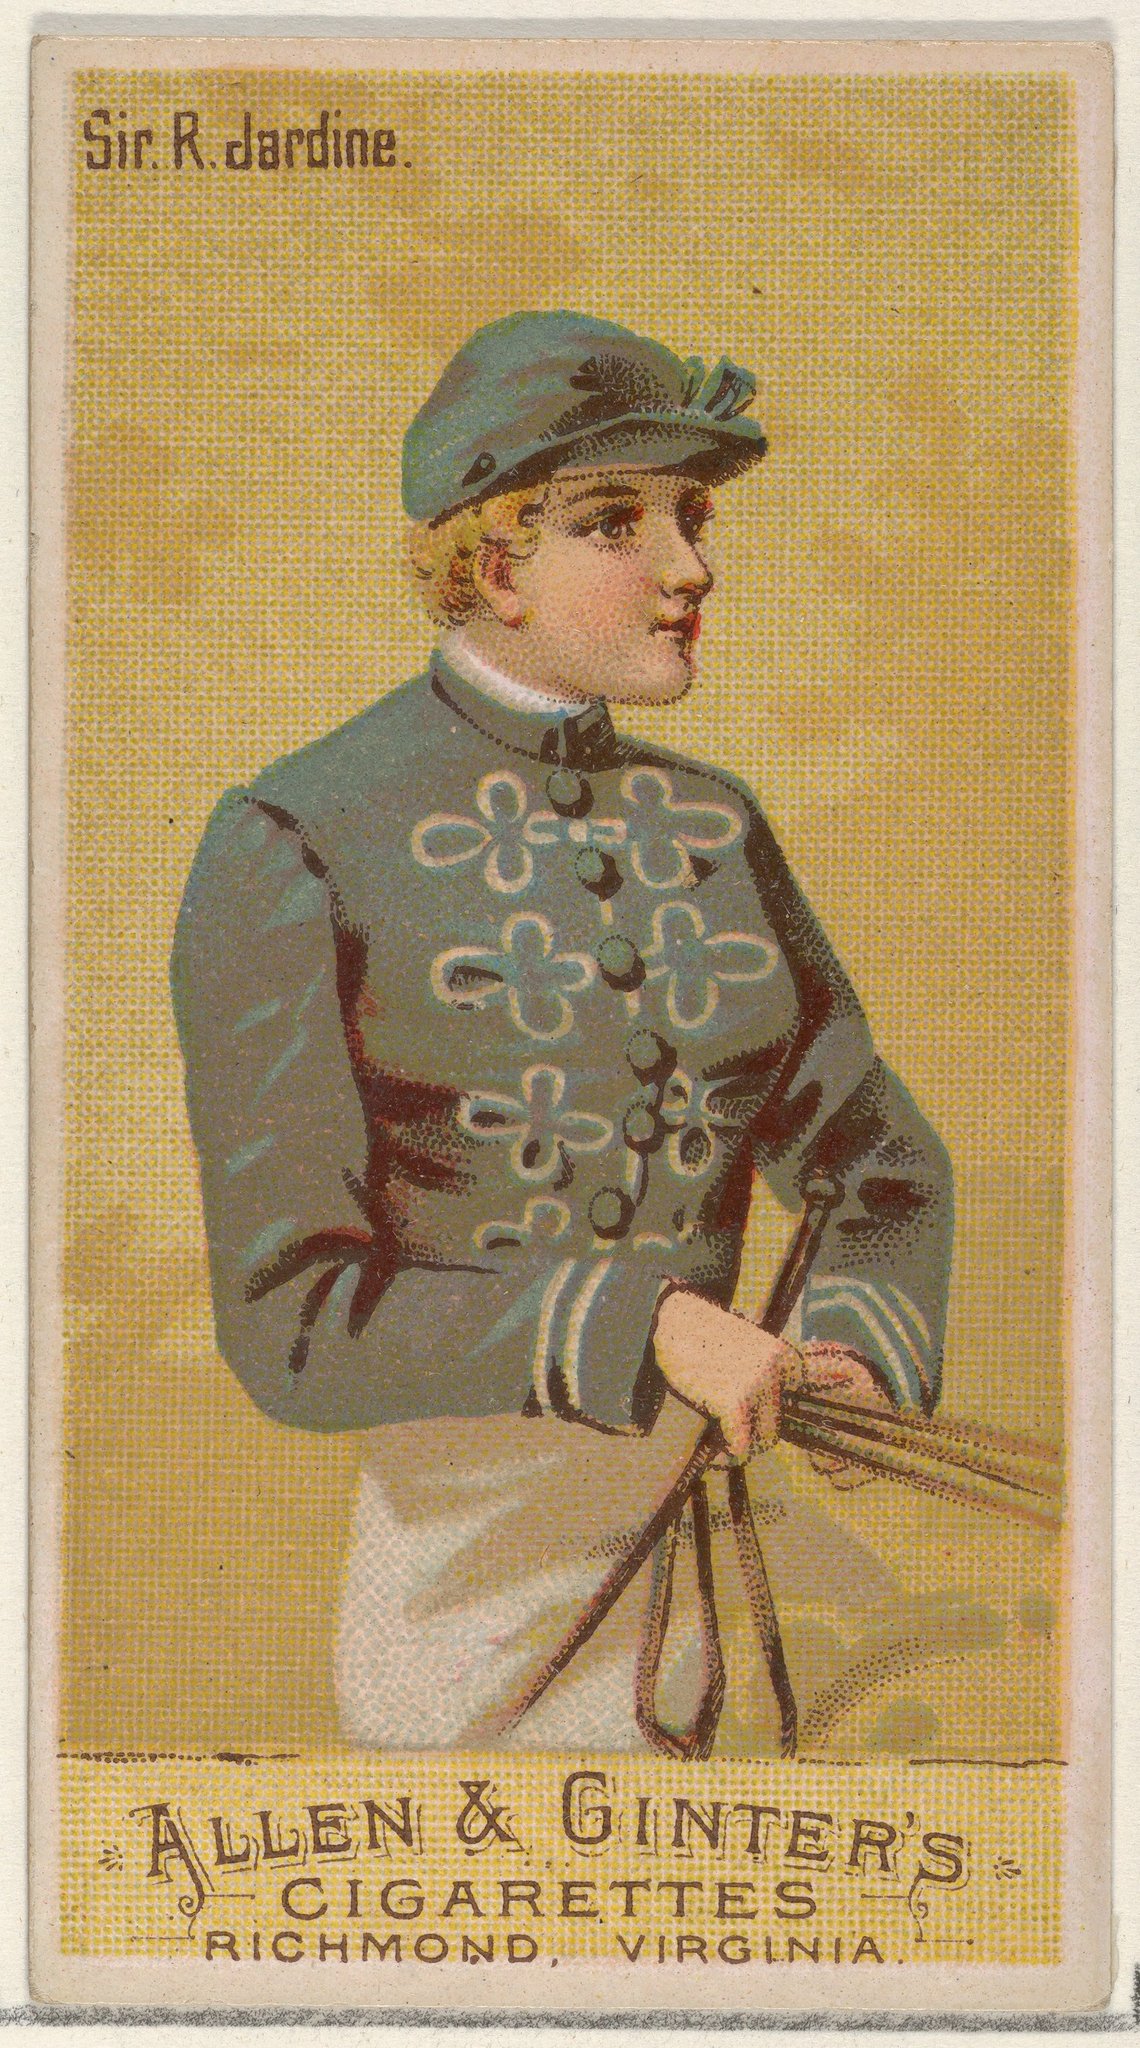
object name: print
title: Sir R. Jardine, from the Racing Colors of the World series (N22a) for Allen & Ginter Cigarettes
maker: allen & ginter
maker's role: publisher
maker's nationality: american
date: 1888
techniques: color lithograph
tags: men,jockeys